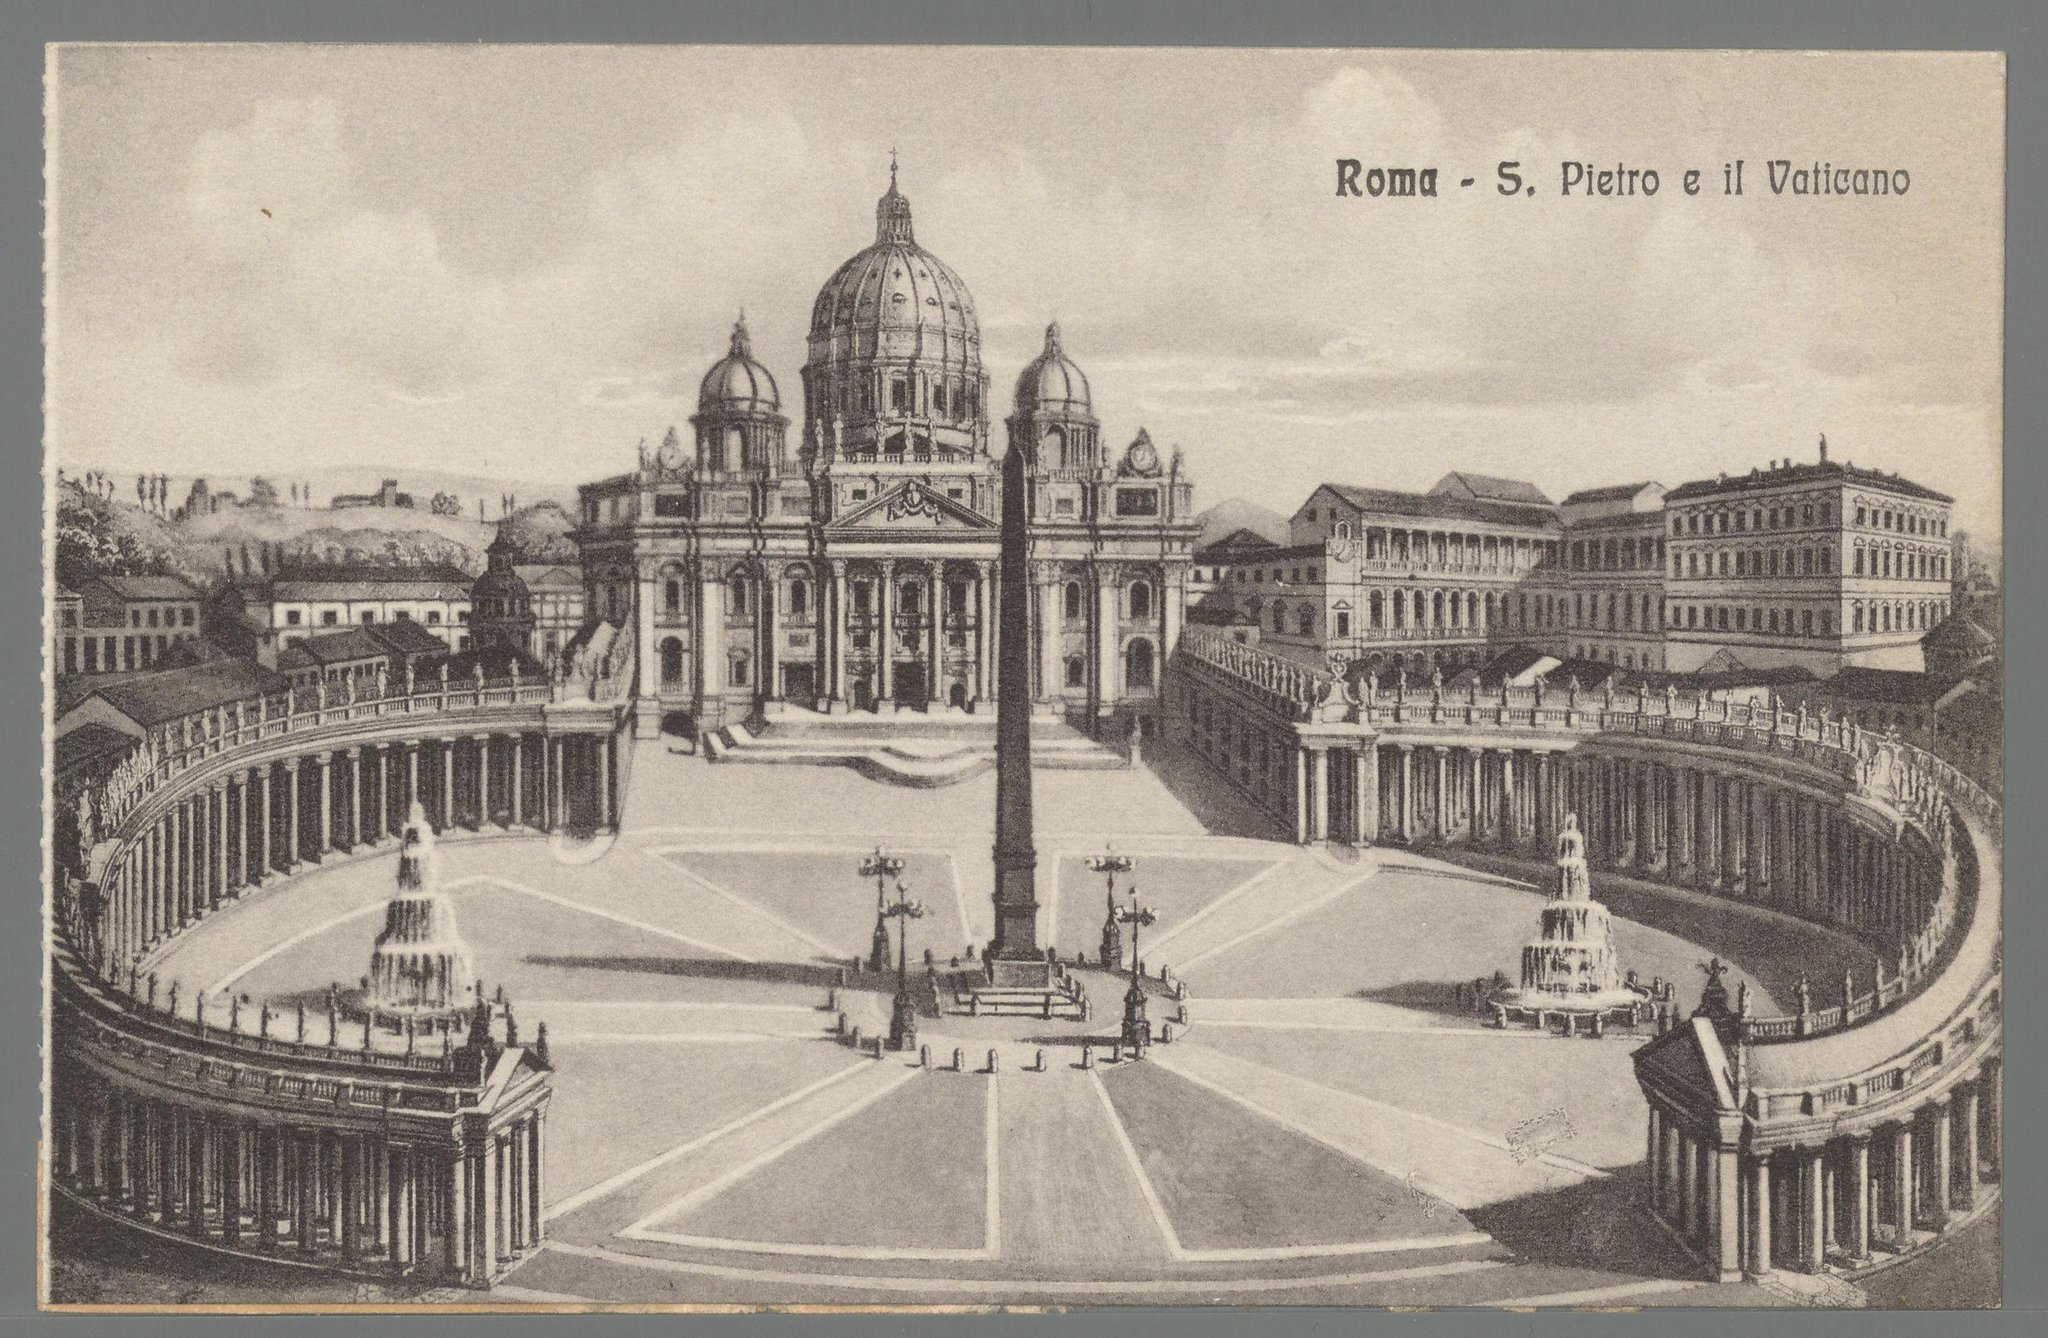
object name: reproduction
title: Roma. S. Pietro e il Vaticano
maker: Anonymous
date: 1910-1930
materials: cardboard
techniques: photograph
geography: terni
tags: square, place, circus, etc., city-view, and landscape with man-made constructions, church (exterior)